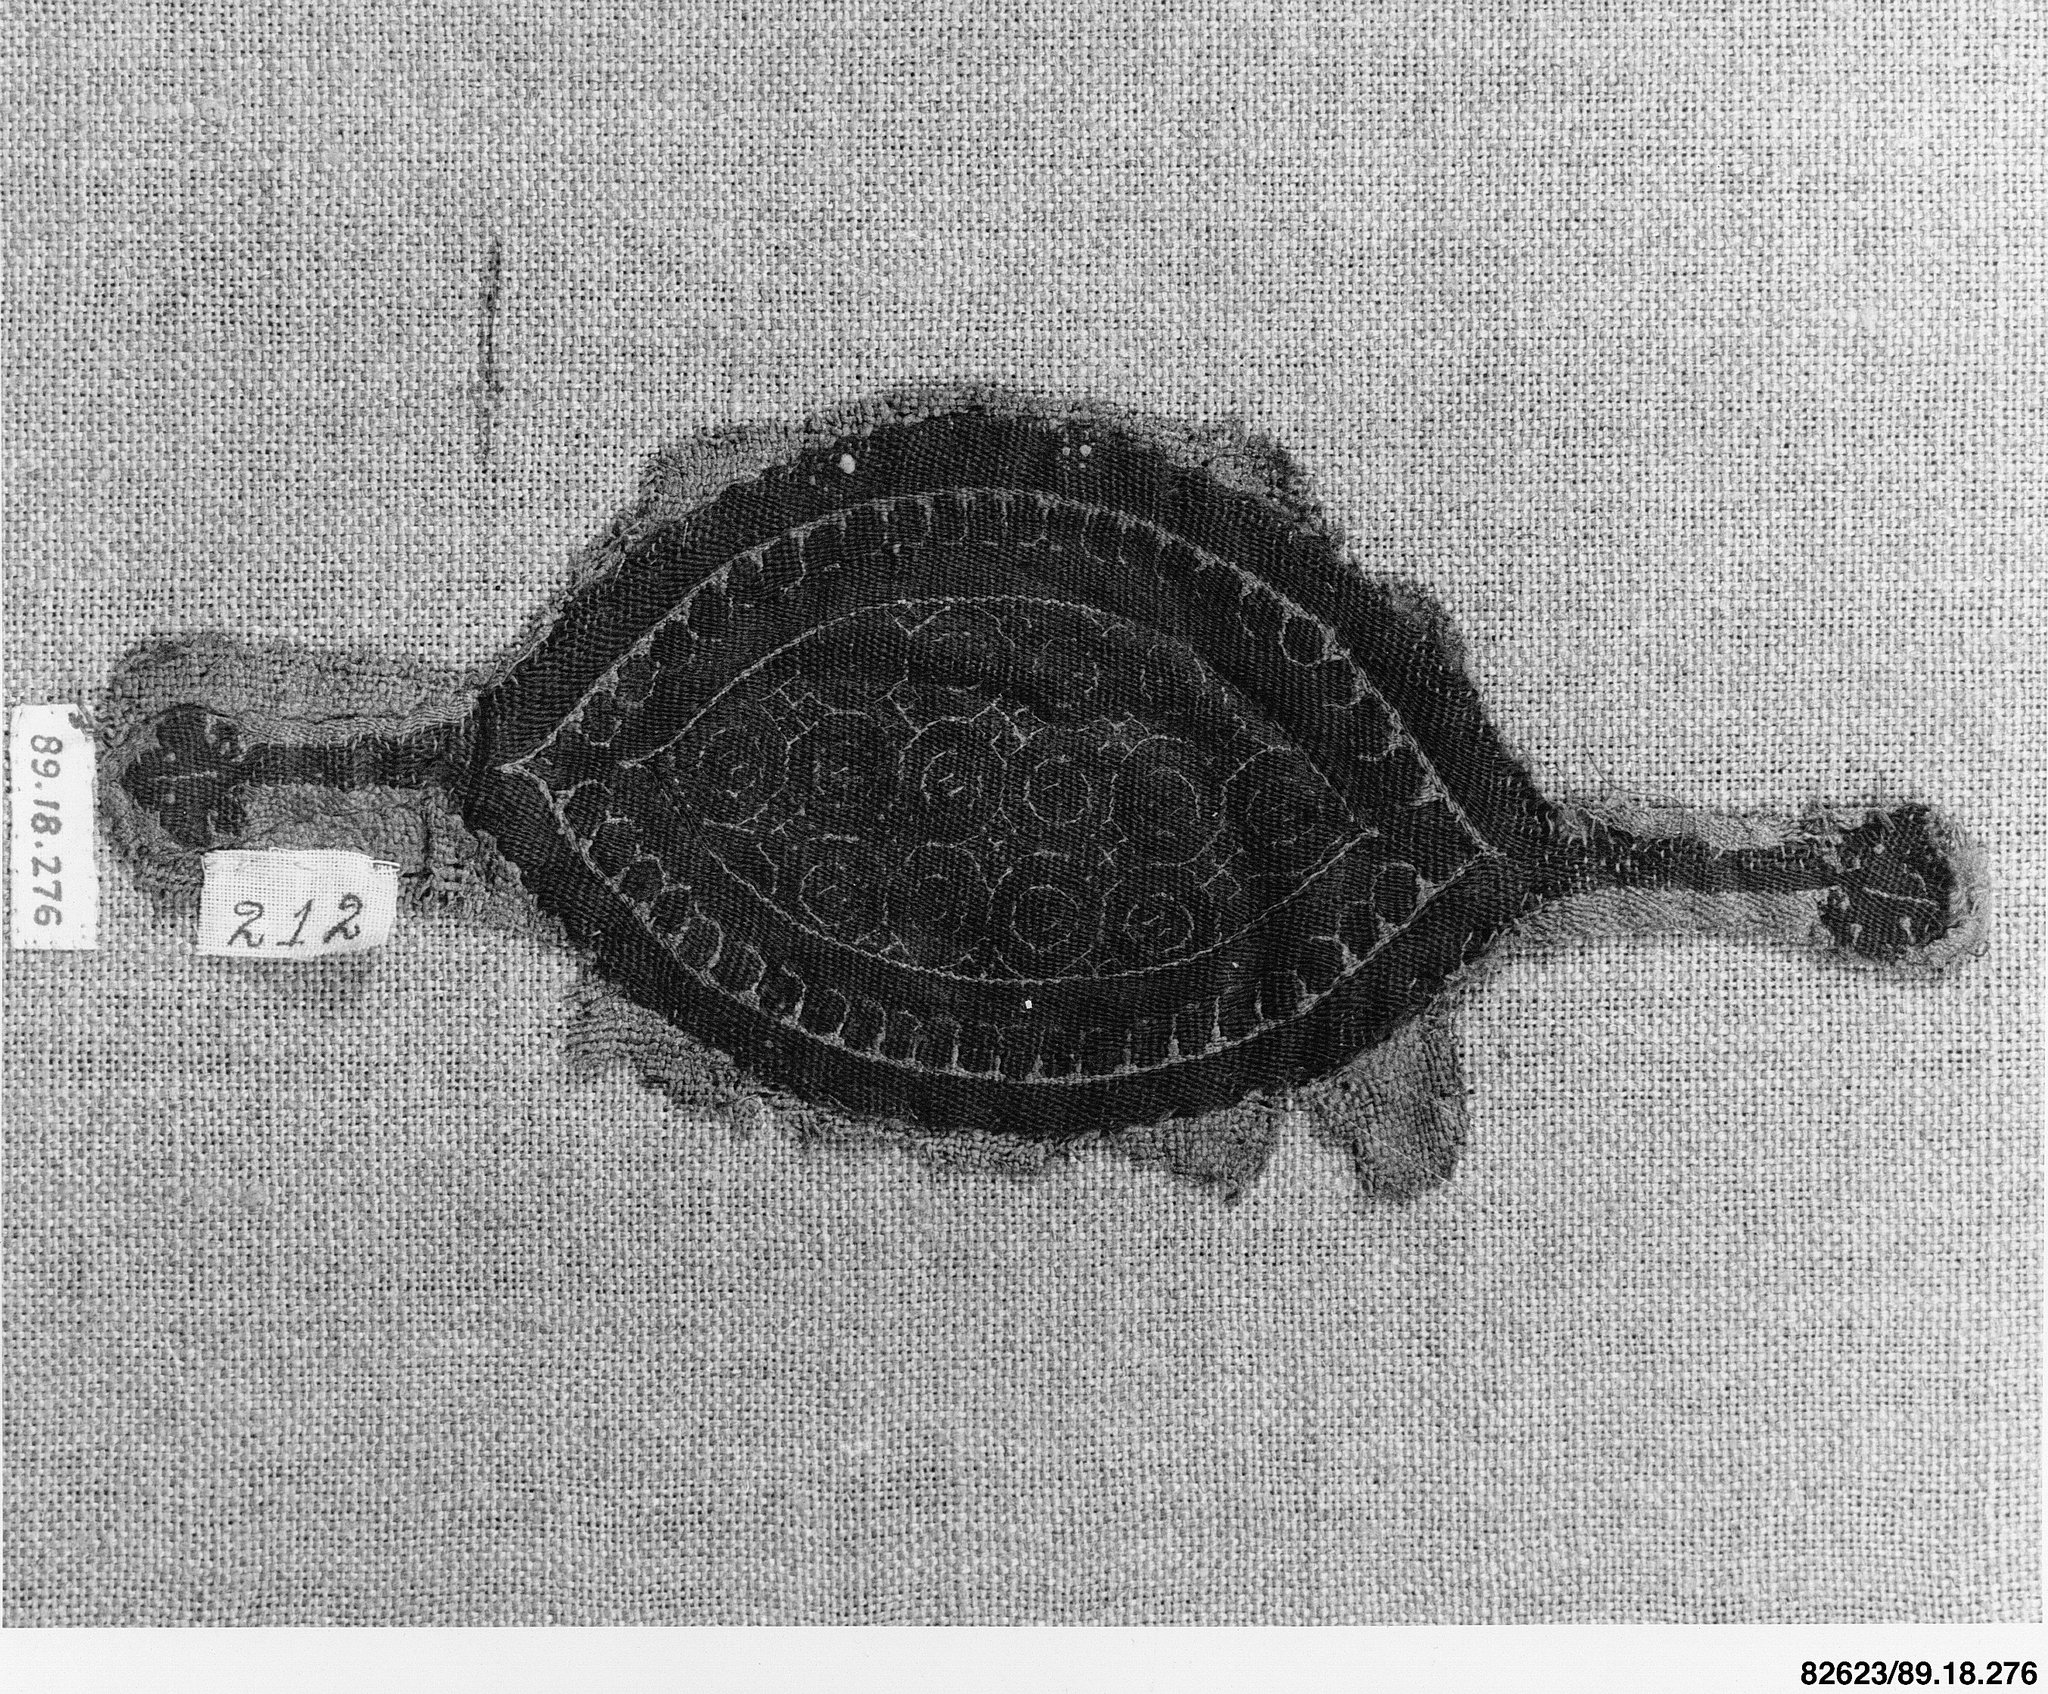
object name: textile fragment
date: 301-400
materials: linen, wool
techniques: weave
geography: egypt